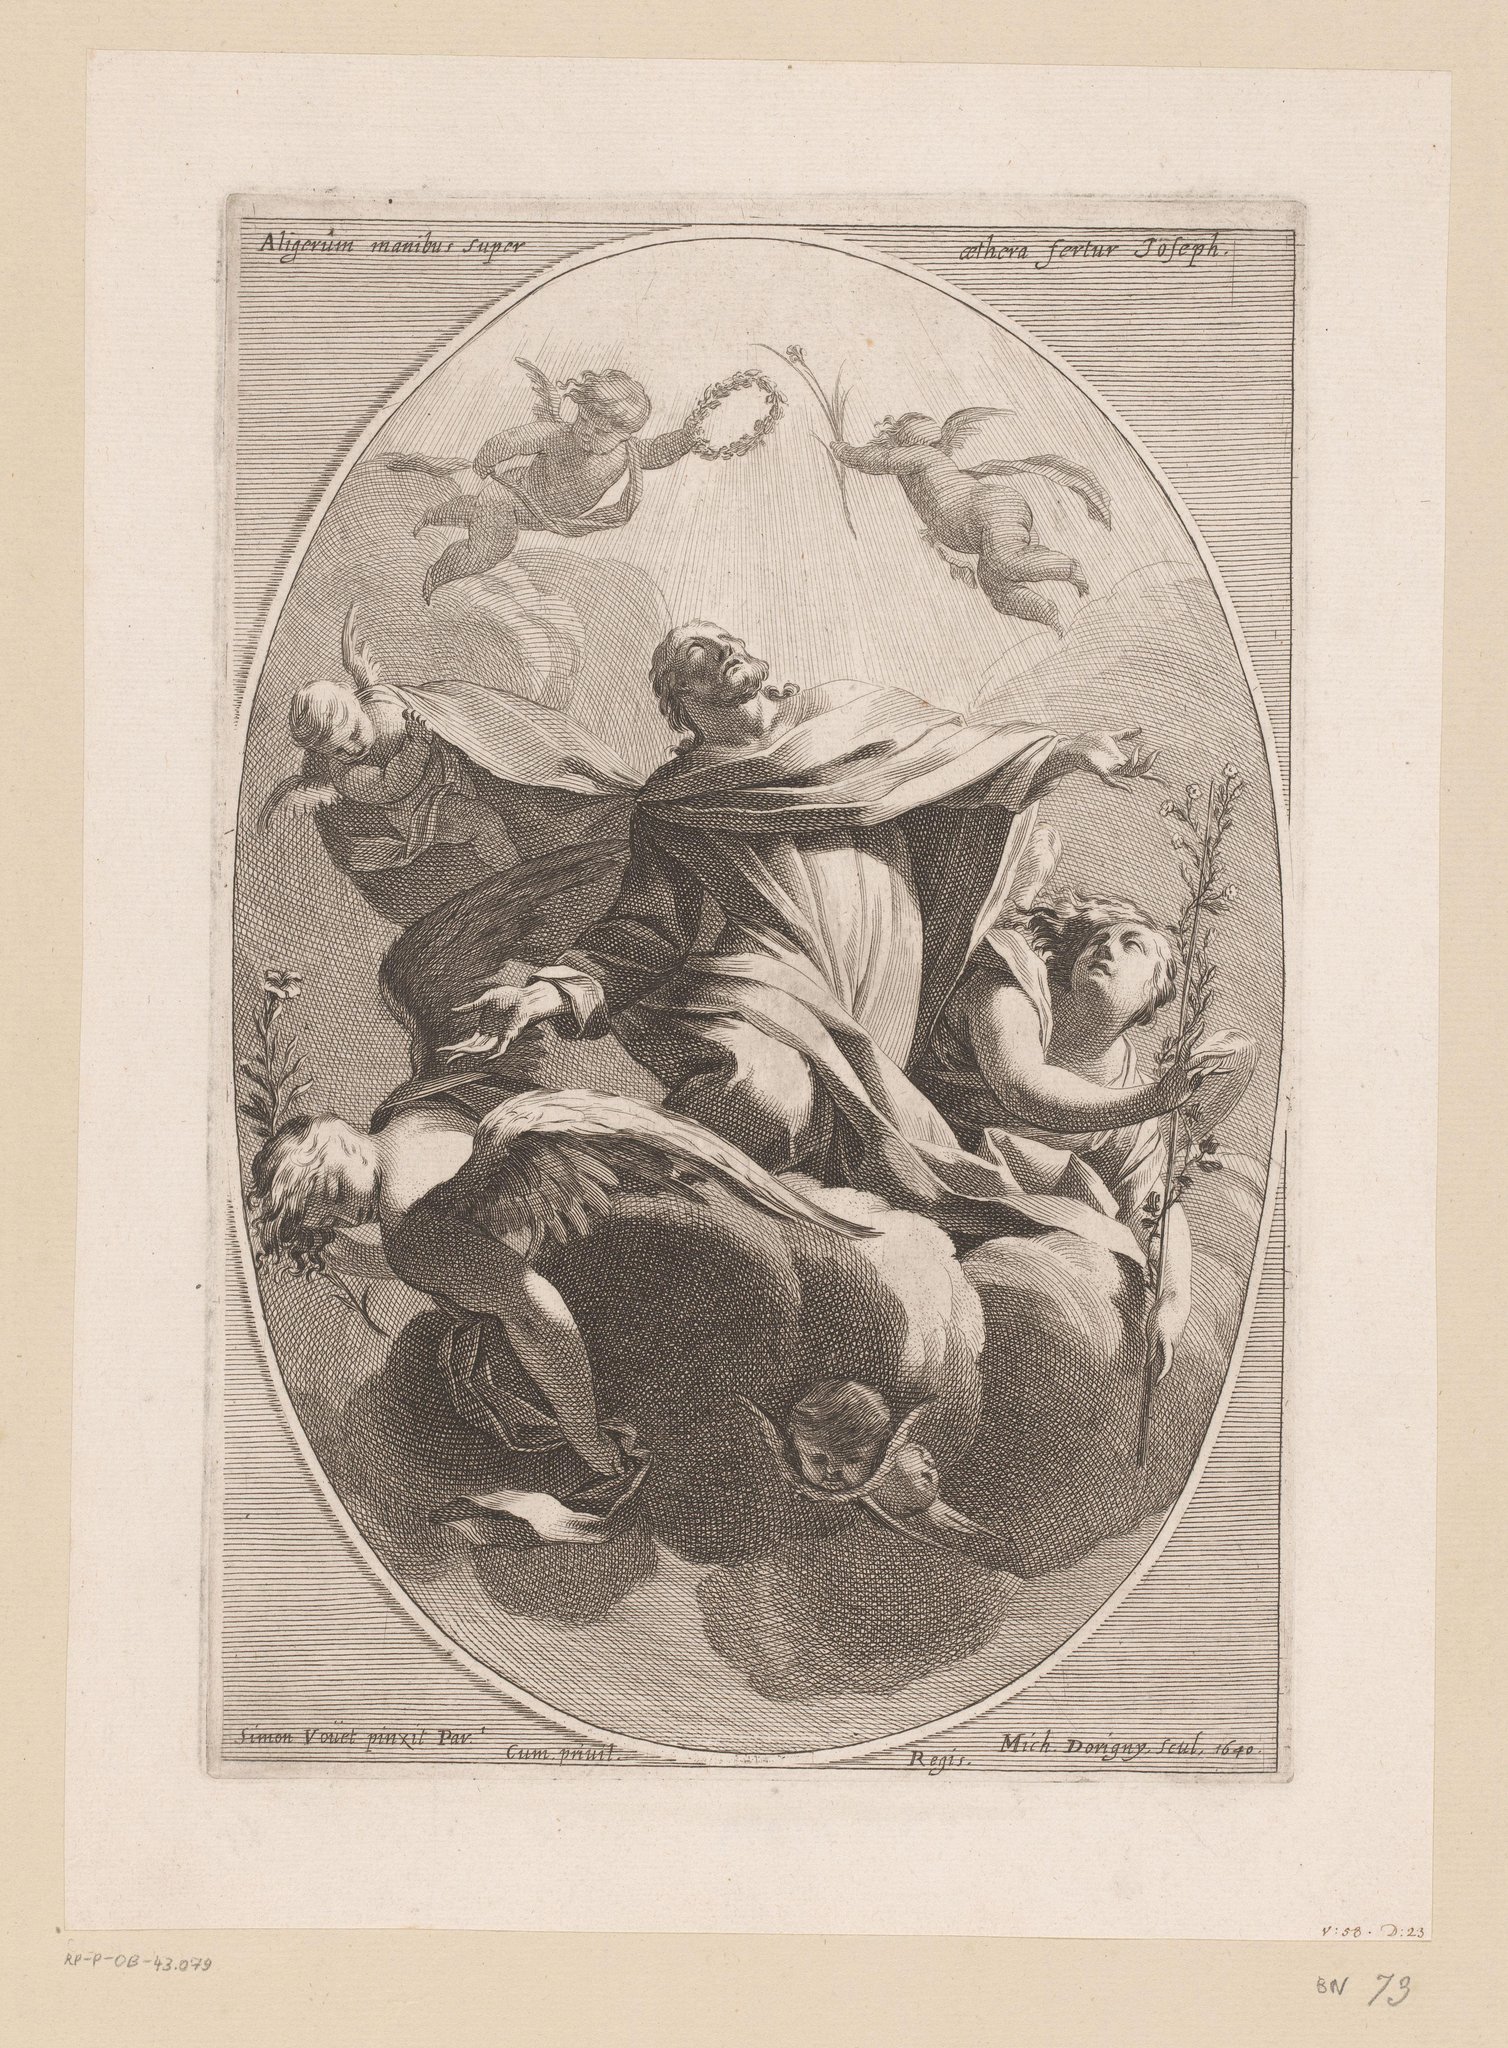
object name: print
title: Aligerum manibus super aethera fertur Joseph.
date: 1640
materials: paper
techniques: engraving, etching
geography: france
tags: the foster-father of christ, joseph of nazareth, husband of mary; possible attributes: flowering rod or wand, lily, carpenter's tools - death, deathbed of male saint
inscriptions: collector's mark: Lugt 240